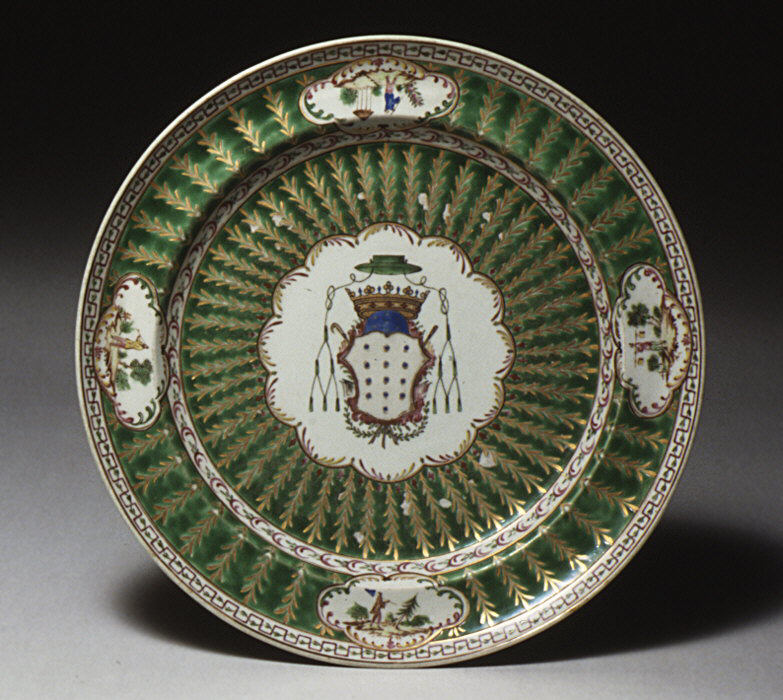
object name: chop plate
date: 1800-1810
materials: hard paste porcelain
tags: human figures,coat of arms